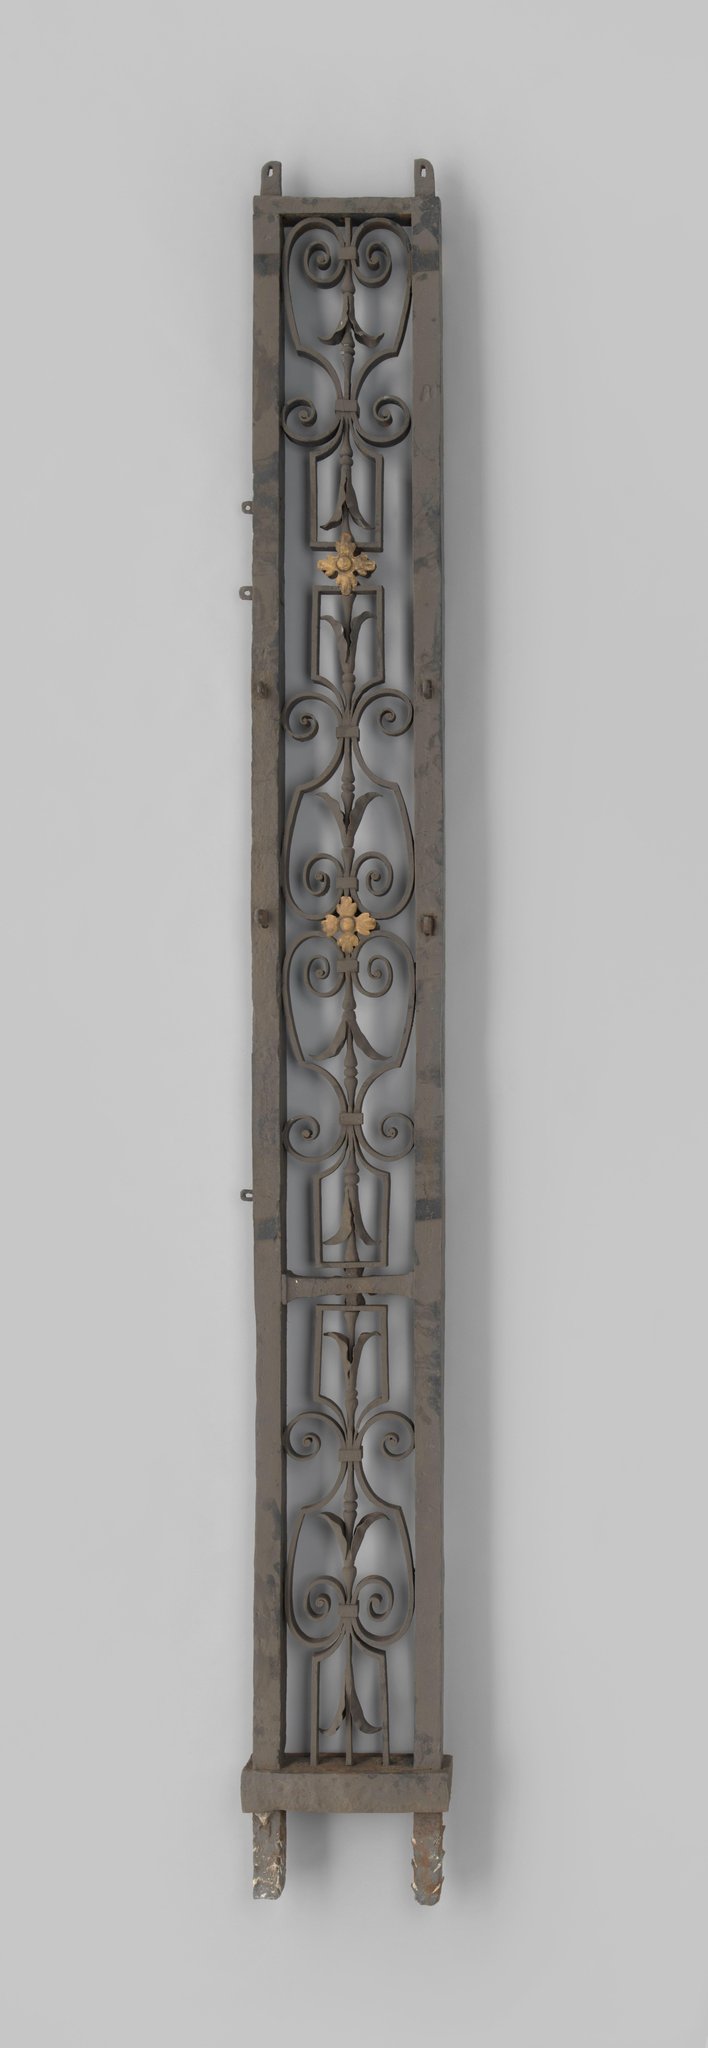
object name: hek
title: Sierhekdeel van het inrijhek Huize de Voorst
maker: daniël marot (i)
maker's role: draughtsman, print maker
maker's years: 1661-1752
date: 1675-1700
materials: iron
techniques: forging, gilding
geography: warnsveld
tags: huis de voorst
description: Smeedijzeren sierhekdeel van het inrijhek van Huize de Voorst.